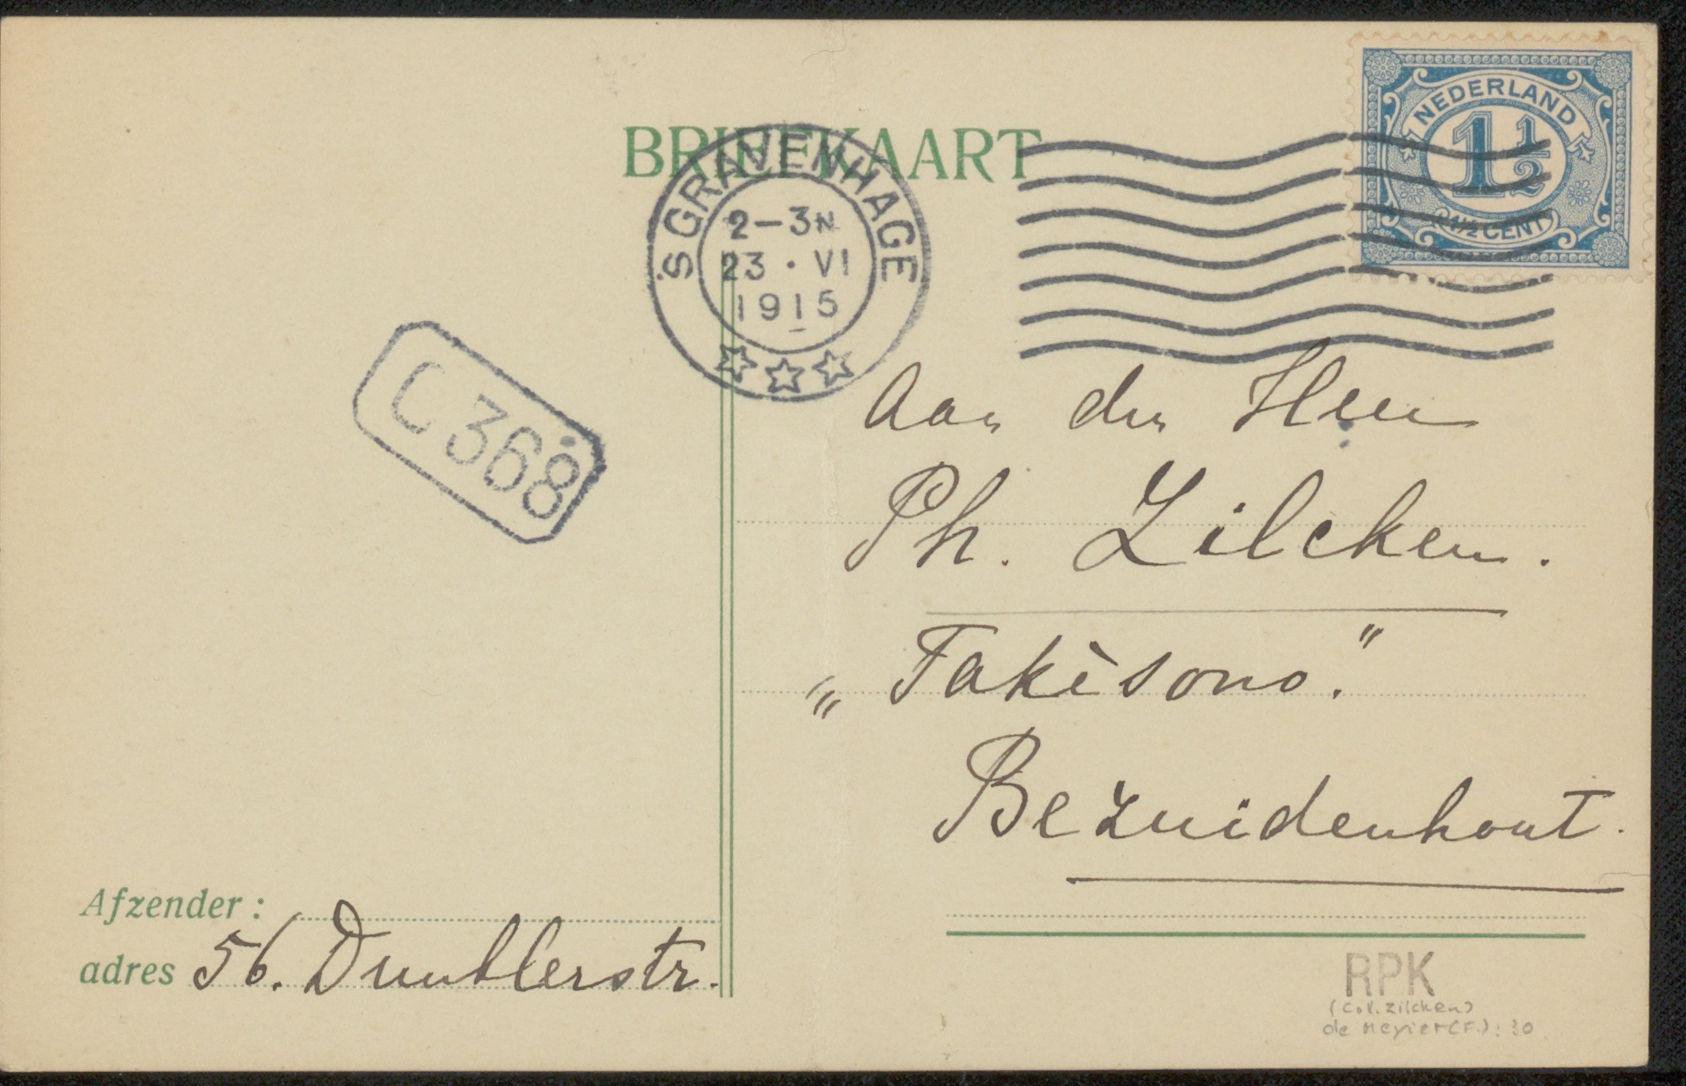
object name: postcard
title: Briefkaart aan Philip Zilcken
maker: fenna de meyier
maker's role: onderwijzer, schrijver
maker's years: 1874-1943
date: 1915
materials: cardboard, ink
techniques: pen, writing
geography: the hague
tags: painter, draughtsman, philip zilcken, haarlem, rotterdam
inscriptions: collector's mark: ‘RPK’